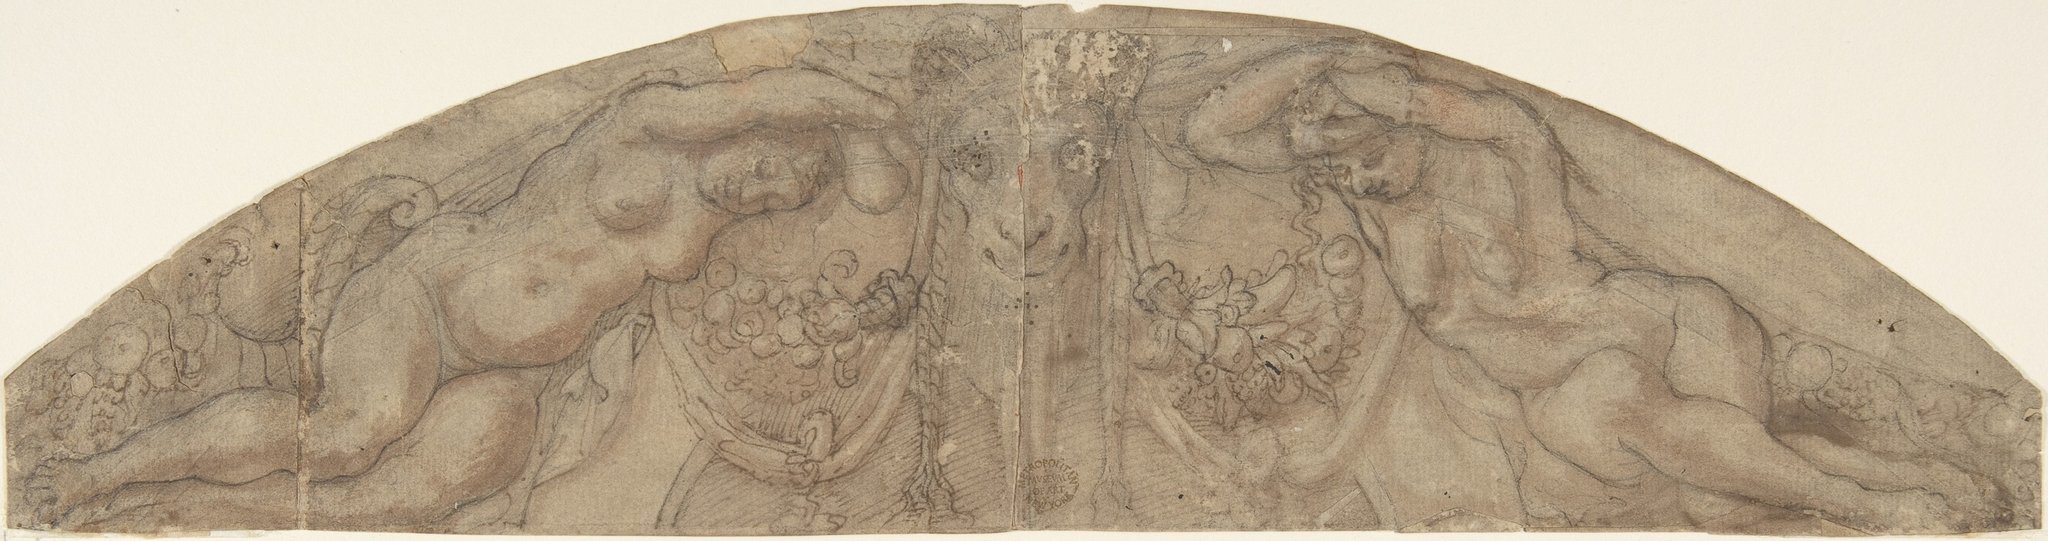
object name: drawing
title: Design for a Lunette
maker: anonymous, italian, 16th century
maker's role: artist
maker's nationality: italian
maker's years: 1550-1600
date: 1501-1600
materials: chalk, ink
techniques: pen, wash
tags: garlands,faces,female nudes